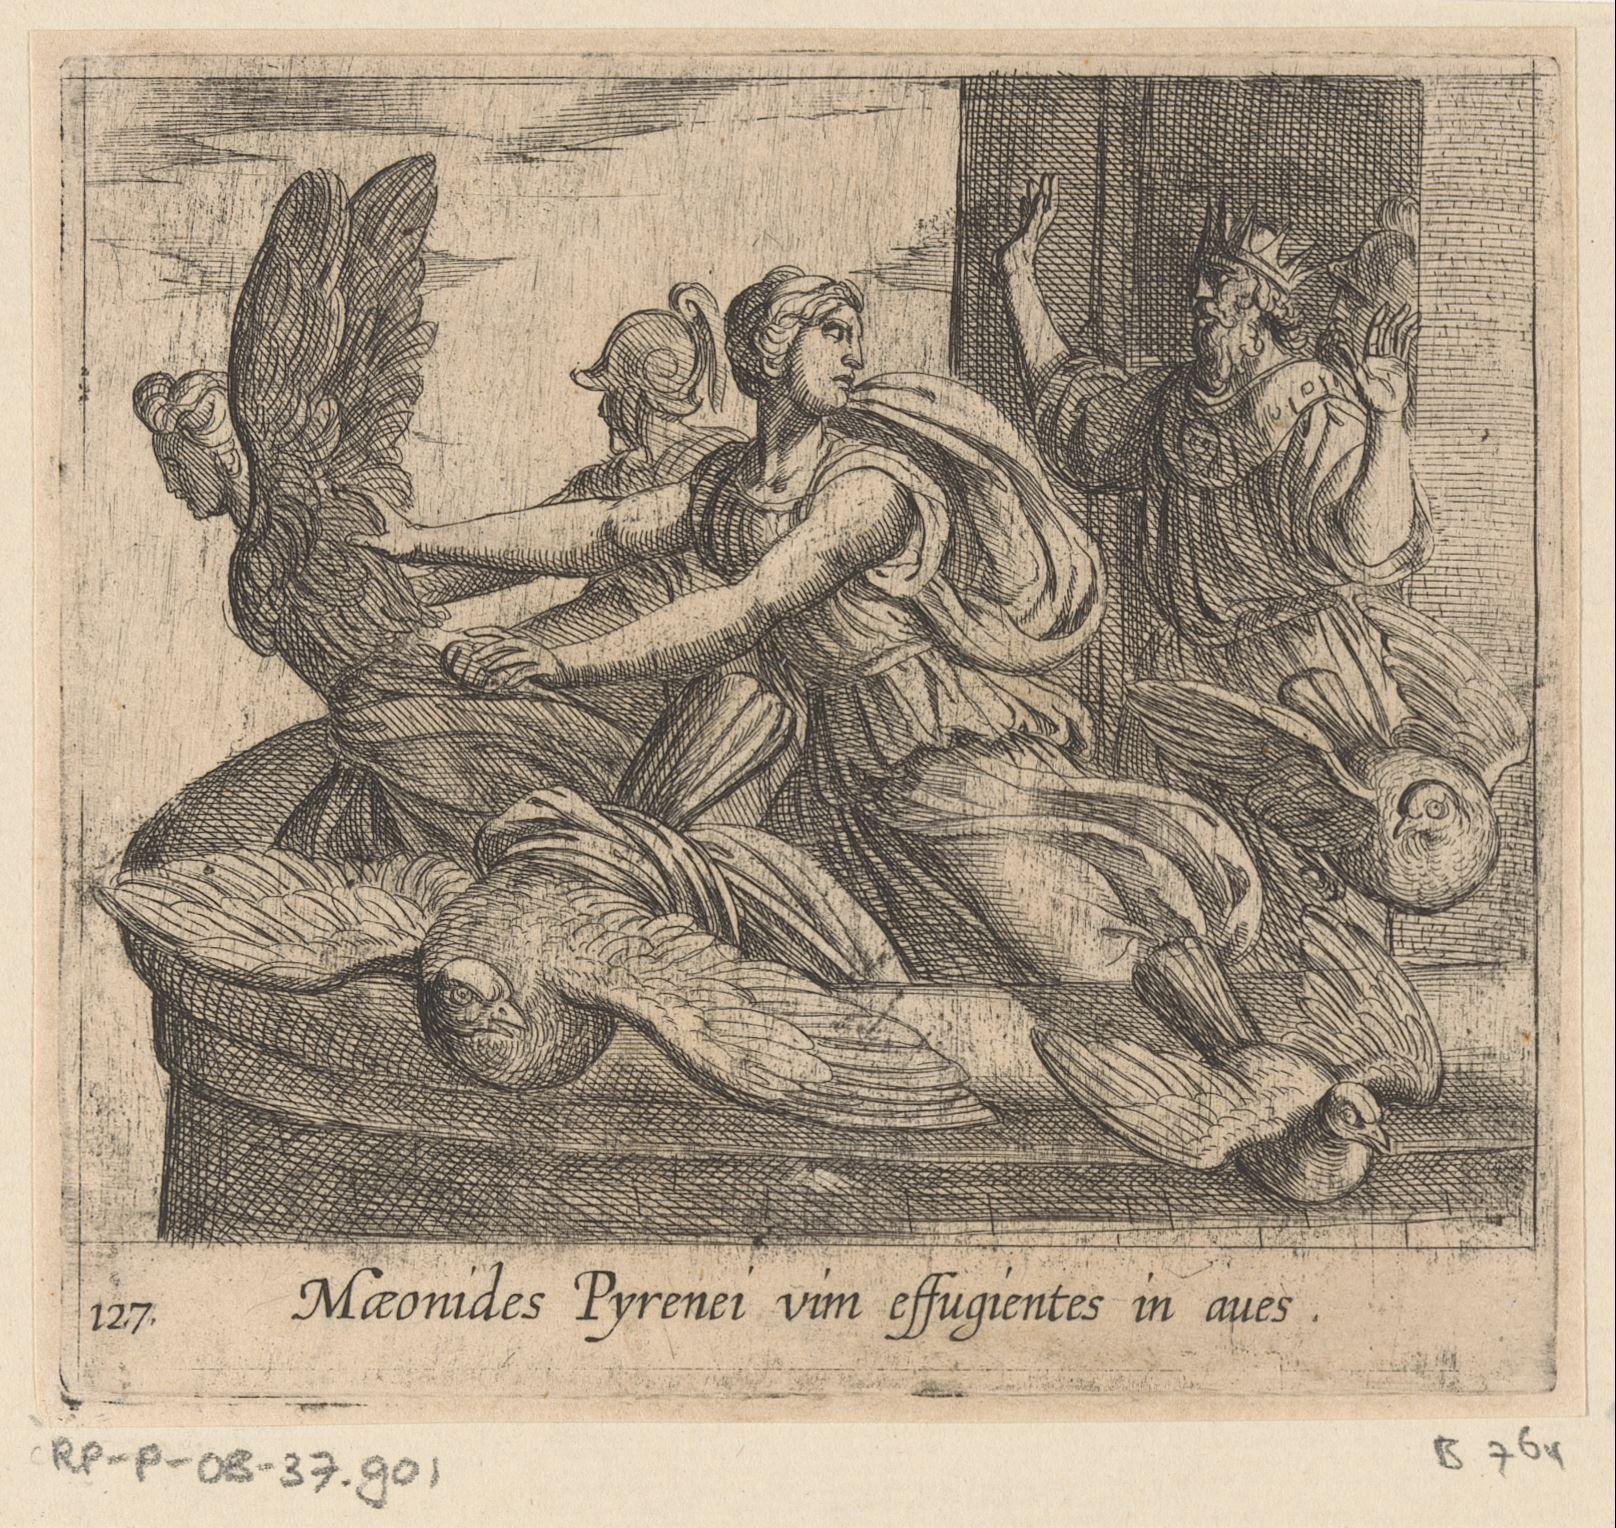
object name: print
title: Dochters van Anius in duiven veranderd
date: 1606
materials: paper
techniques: etching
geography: antwerp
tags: anius' daughters changed into doves: to escape agamemnon, who wishes to carry them with him to troy, anius' daughters are changed into doves by bacchus (ovid, metamorphoses xiii 673)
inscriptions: collector's mark: Lugt 240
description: De dochters van Anius worden in duiven veranderd, zodat zij kunnen ontsnappen aan Agamemnon. Titel in het Latijn in ondermarge.